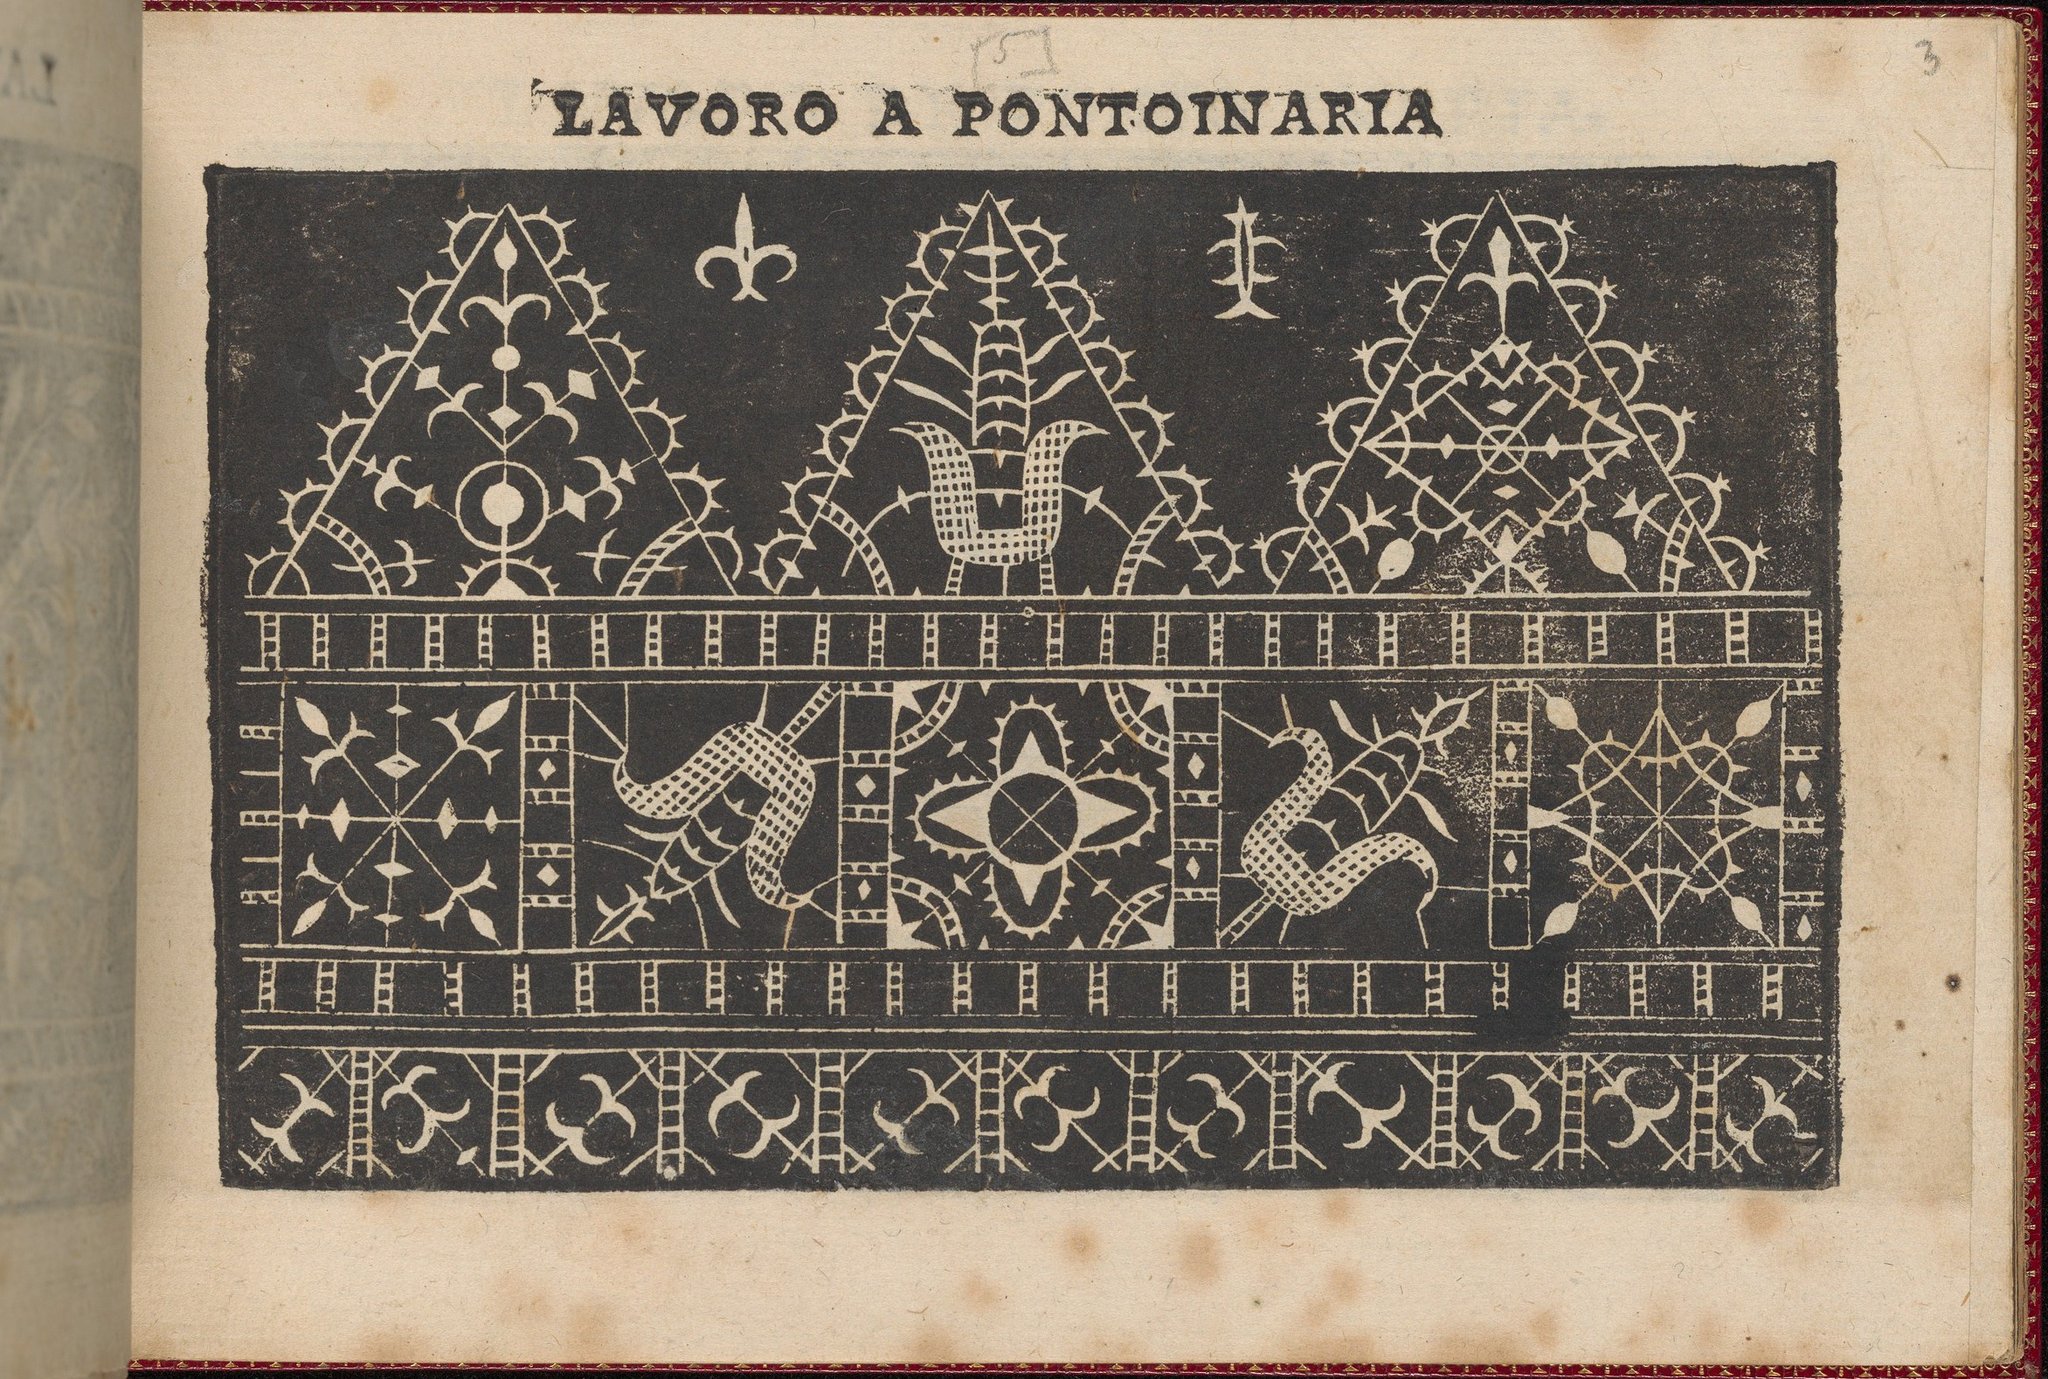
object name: book print ornament architecture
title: Pretiosa Gemma delle virtuose donne, page 5 (recto)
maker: isabella catanea parasole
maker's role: author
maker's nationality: italian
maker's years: 1565-1625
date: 1600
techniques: woodcut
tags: ornament